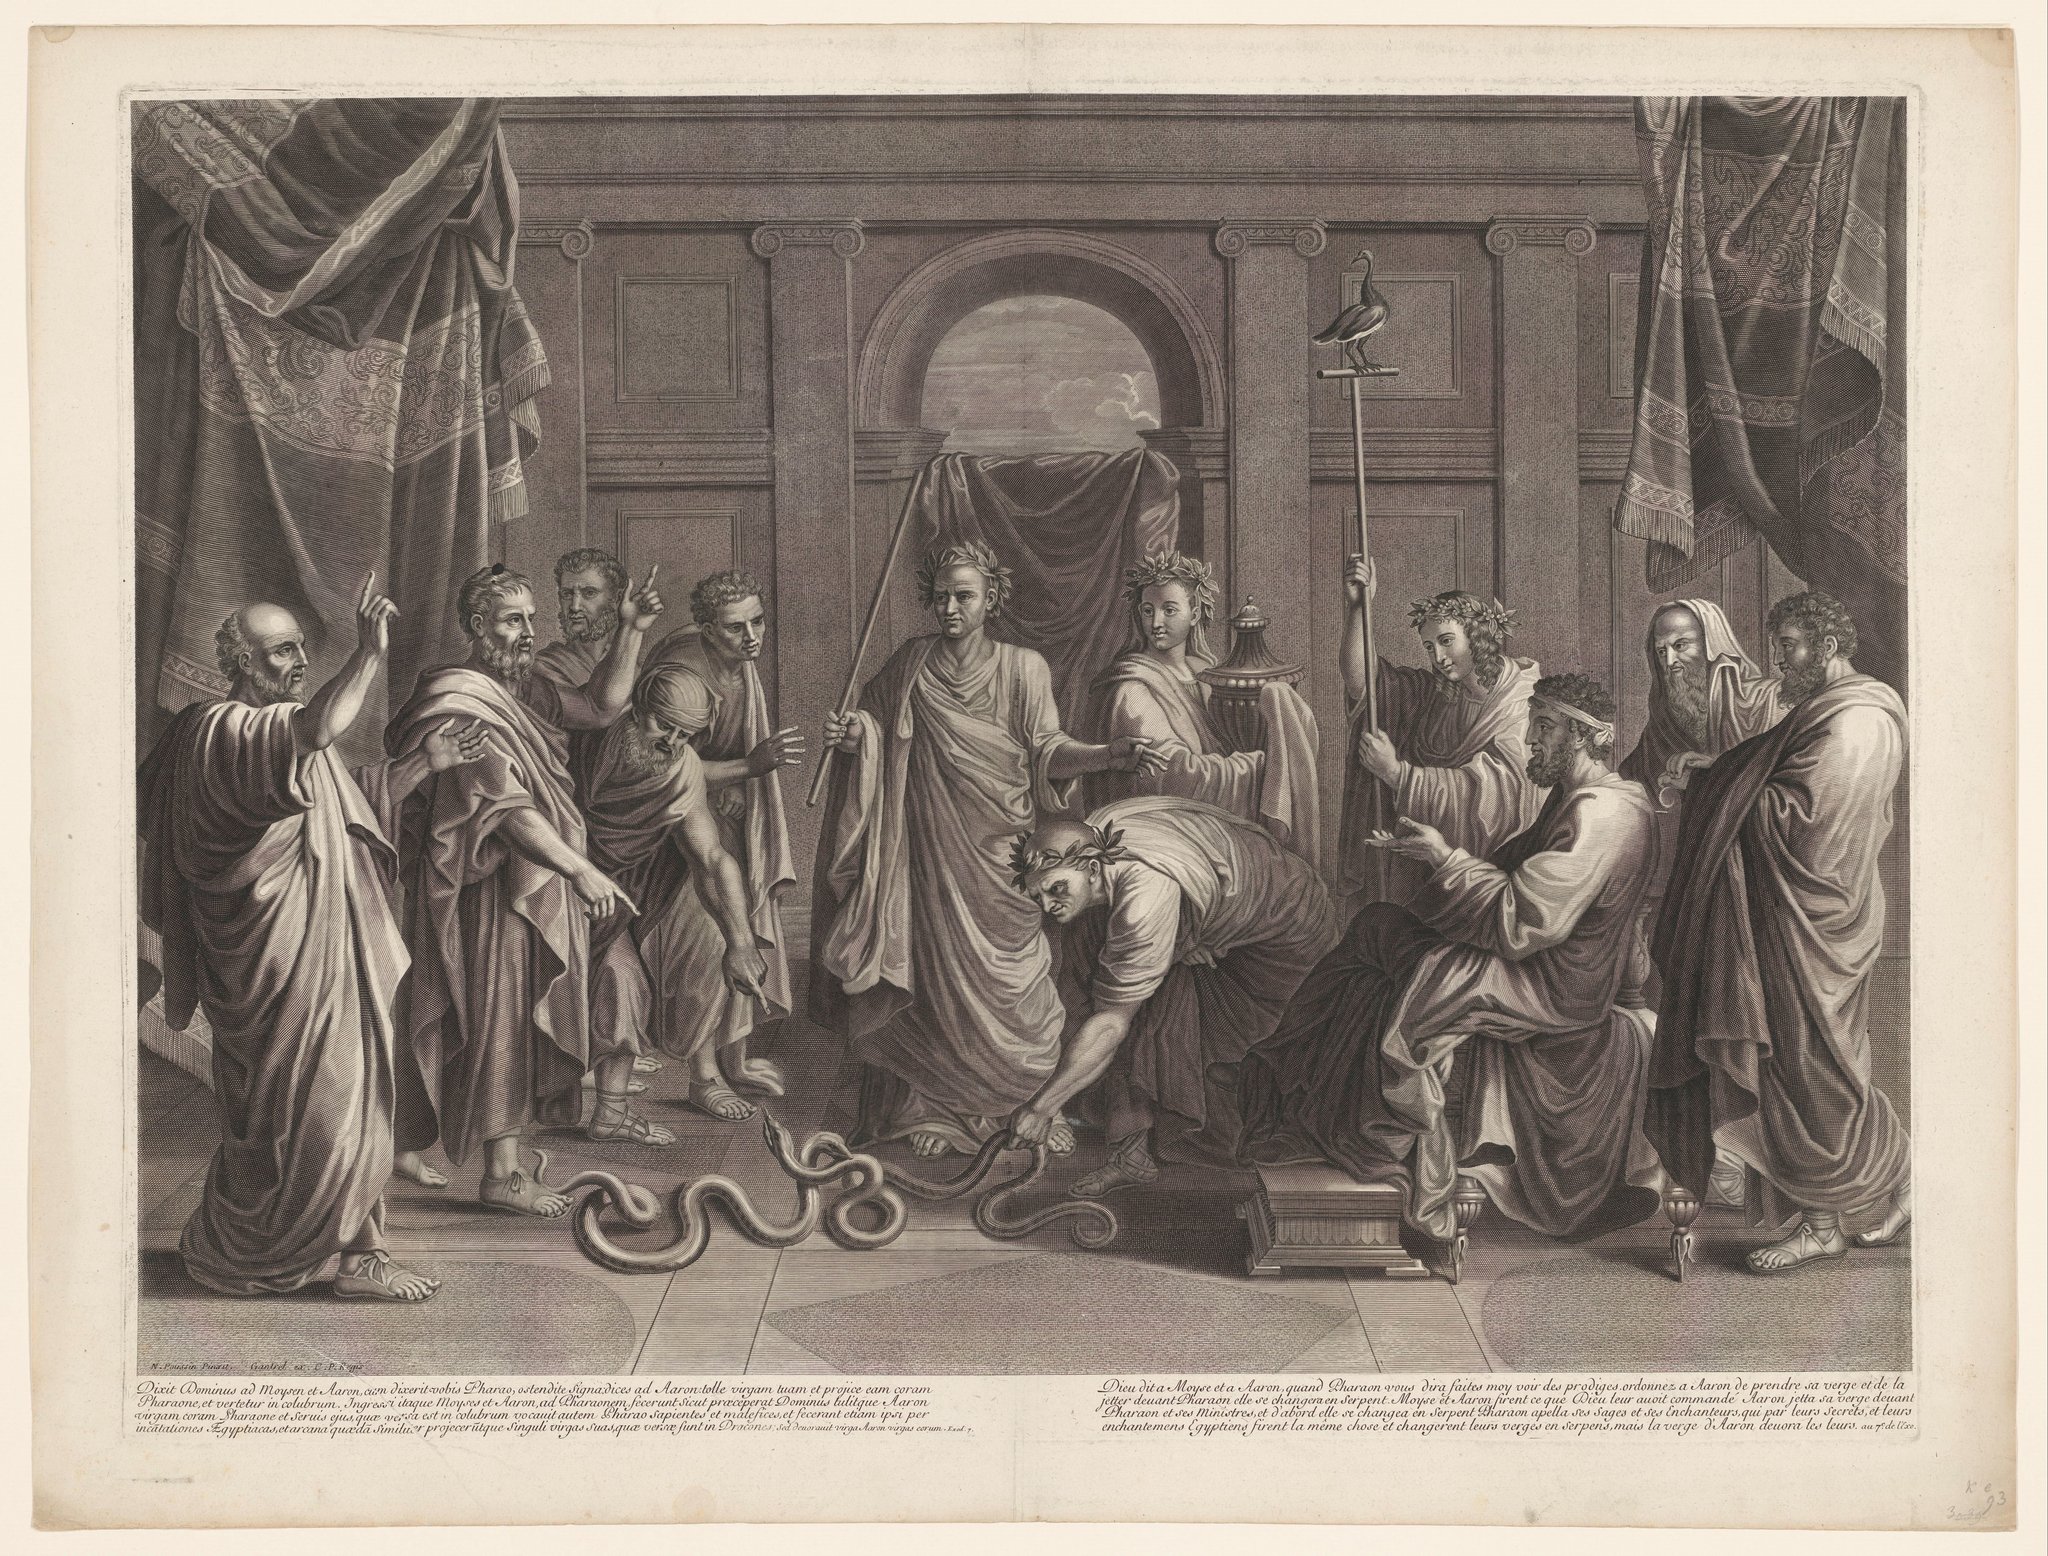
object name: print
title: Mozes verandert zijn staf in een slang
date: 1656-1706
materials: paper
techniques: engraving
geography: paris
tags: moses and aaron before pharaoh; aaron performs the miracle of the rod changing into a snake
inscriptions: collector's mark: Lugt 240